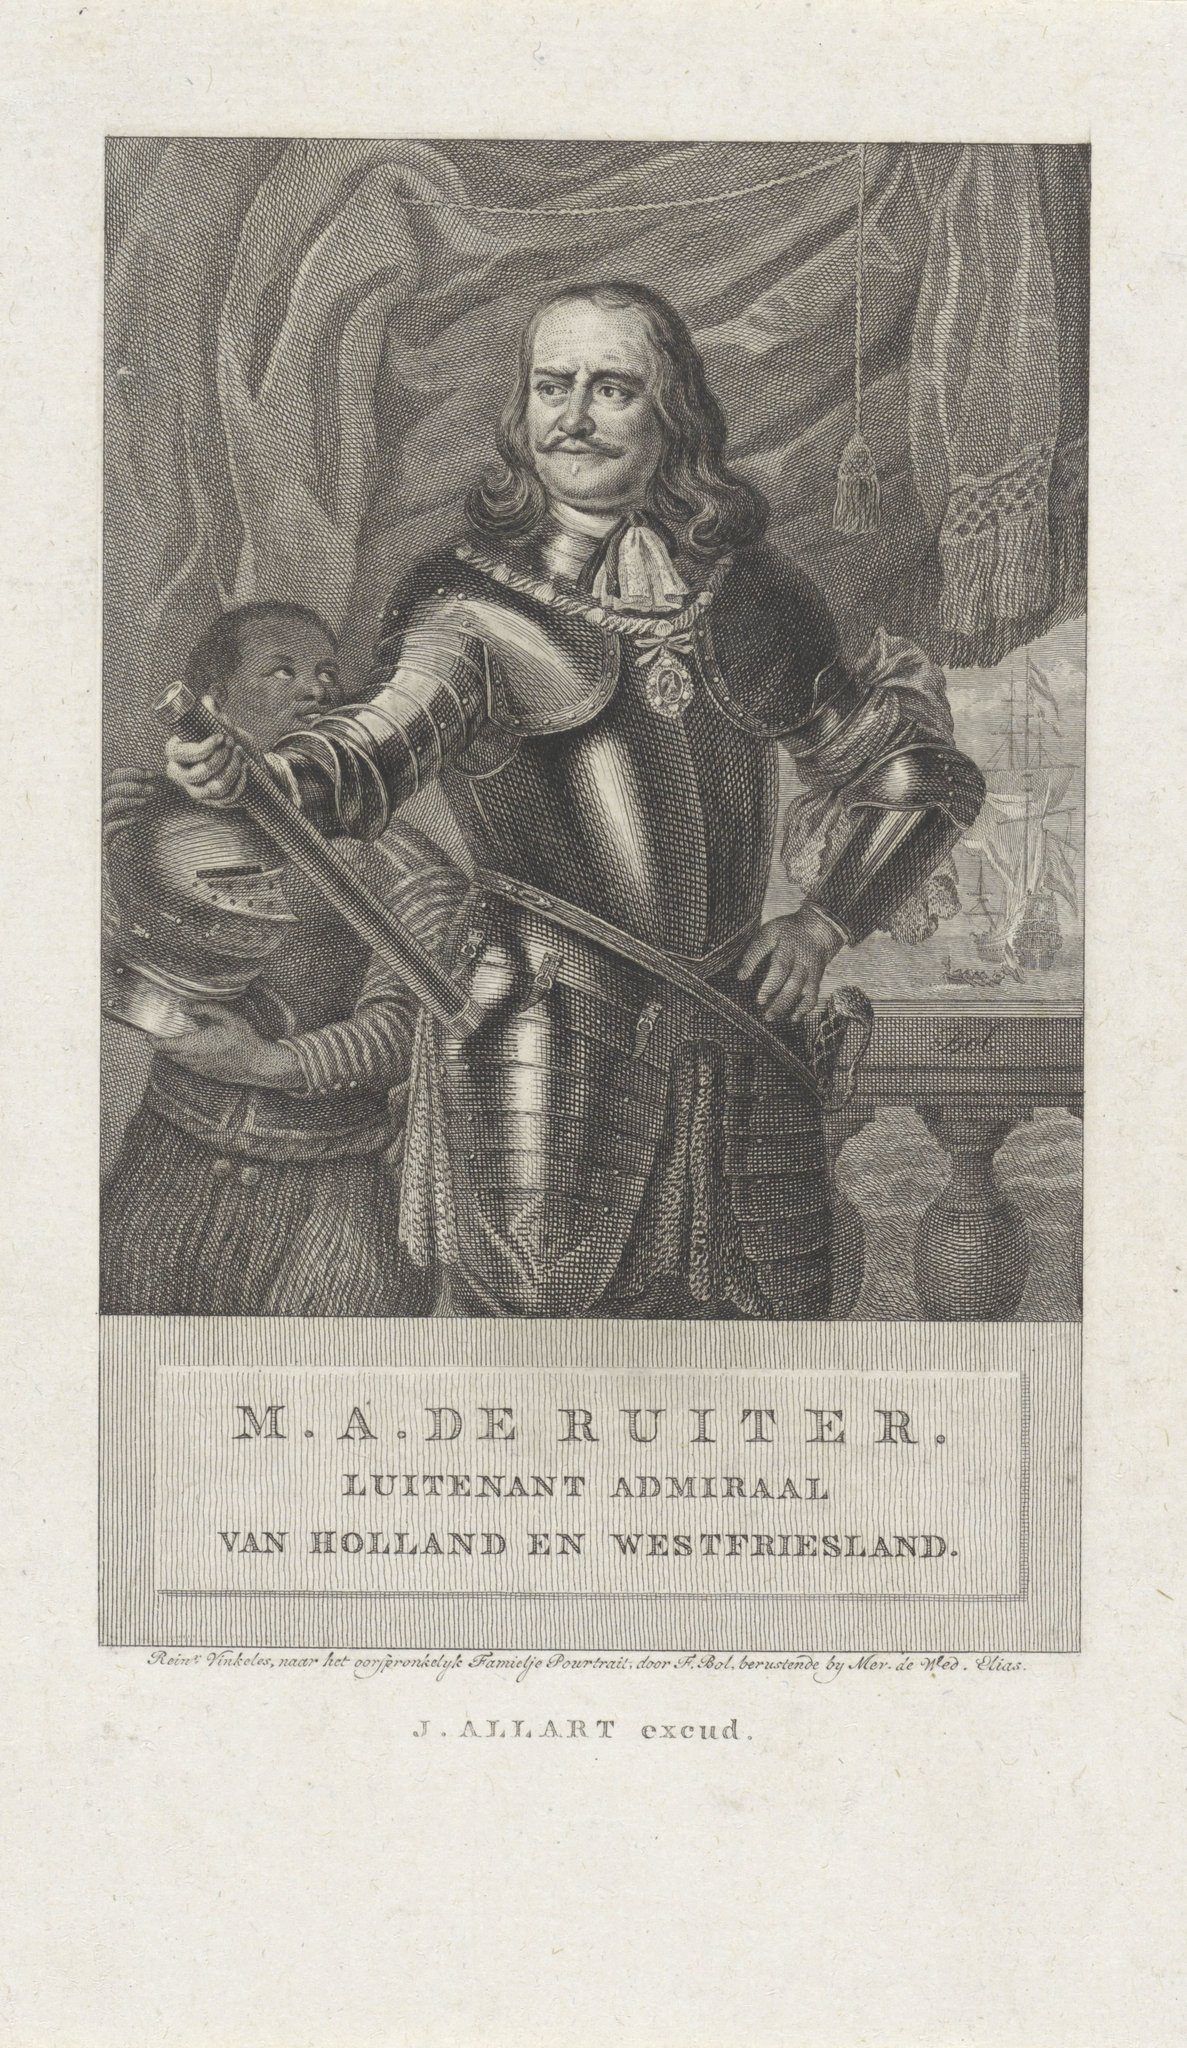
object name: print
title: Portret van Michiel Adriaenszoon de Ruyter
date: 1773-1816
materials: paper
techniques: engraving, etching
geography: amsterdam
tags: michiel adriaenszoon de ruyter, helmet, armour, baton of general, manservant, footman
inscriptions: collector's mark: Lugt 240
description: Portret van de luitenant admiraal Michiel Adriaenszoon de Ruyter, in wapenrusting en met een commandostaf in de hand. Links een dienaar met een helm. Rechts een doorkijk naar een zeilschip en een sloep.